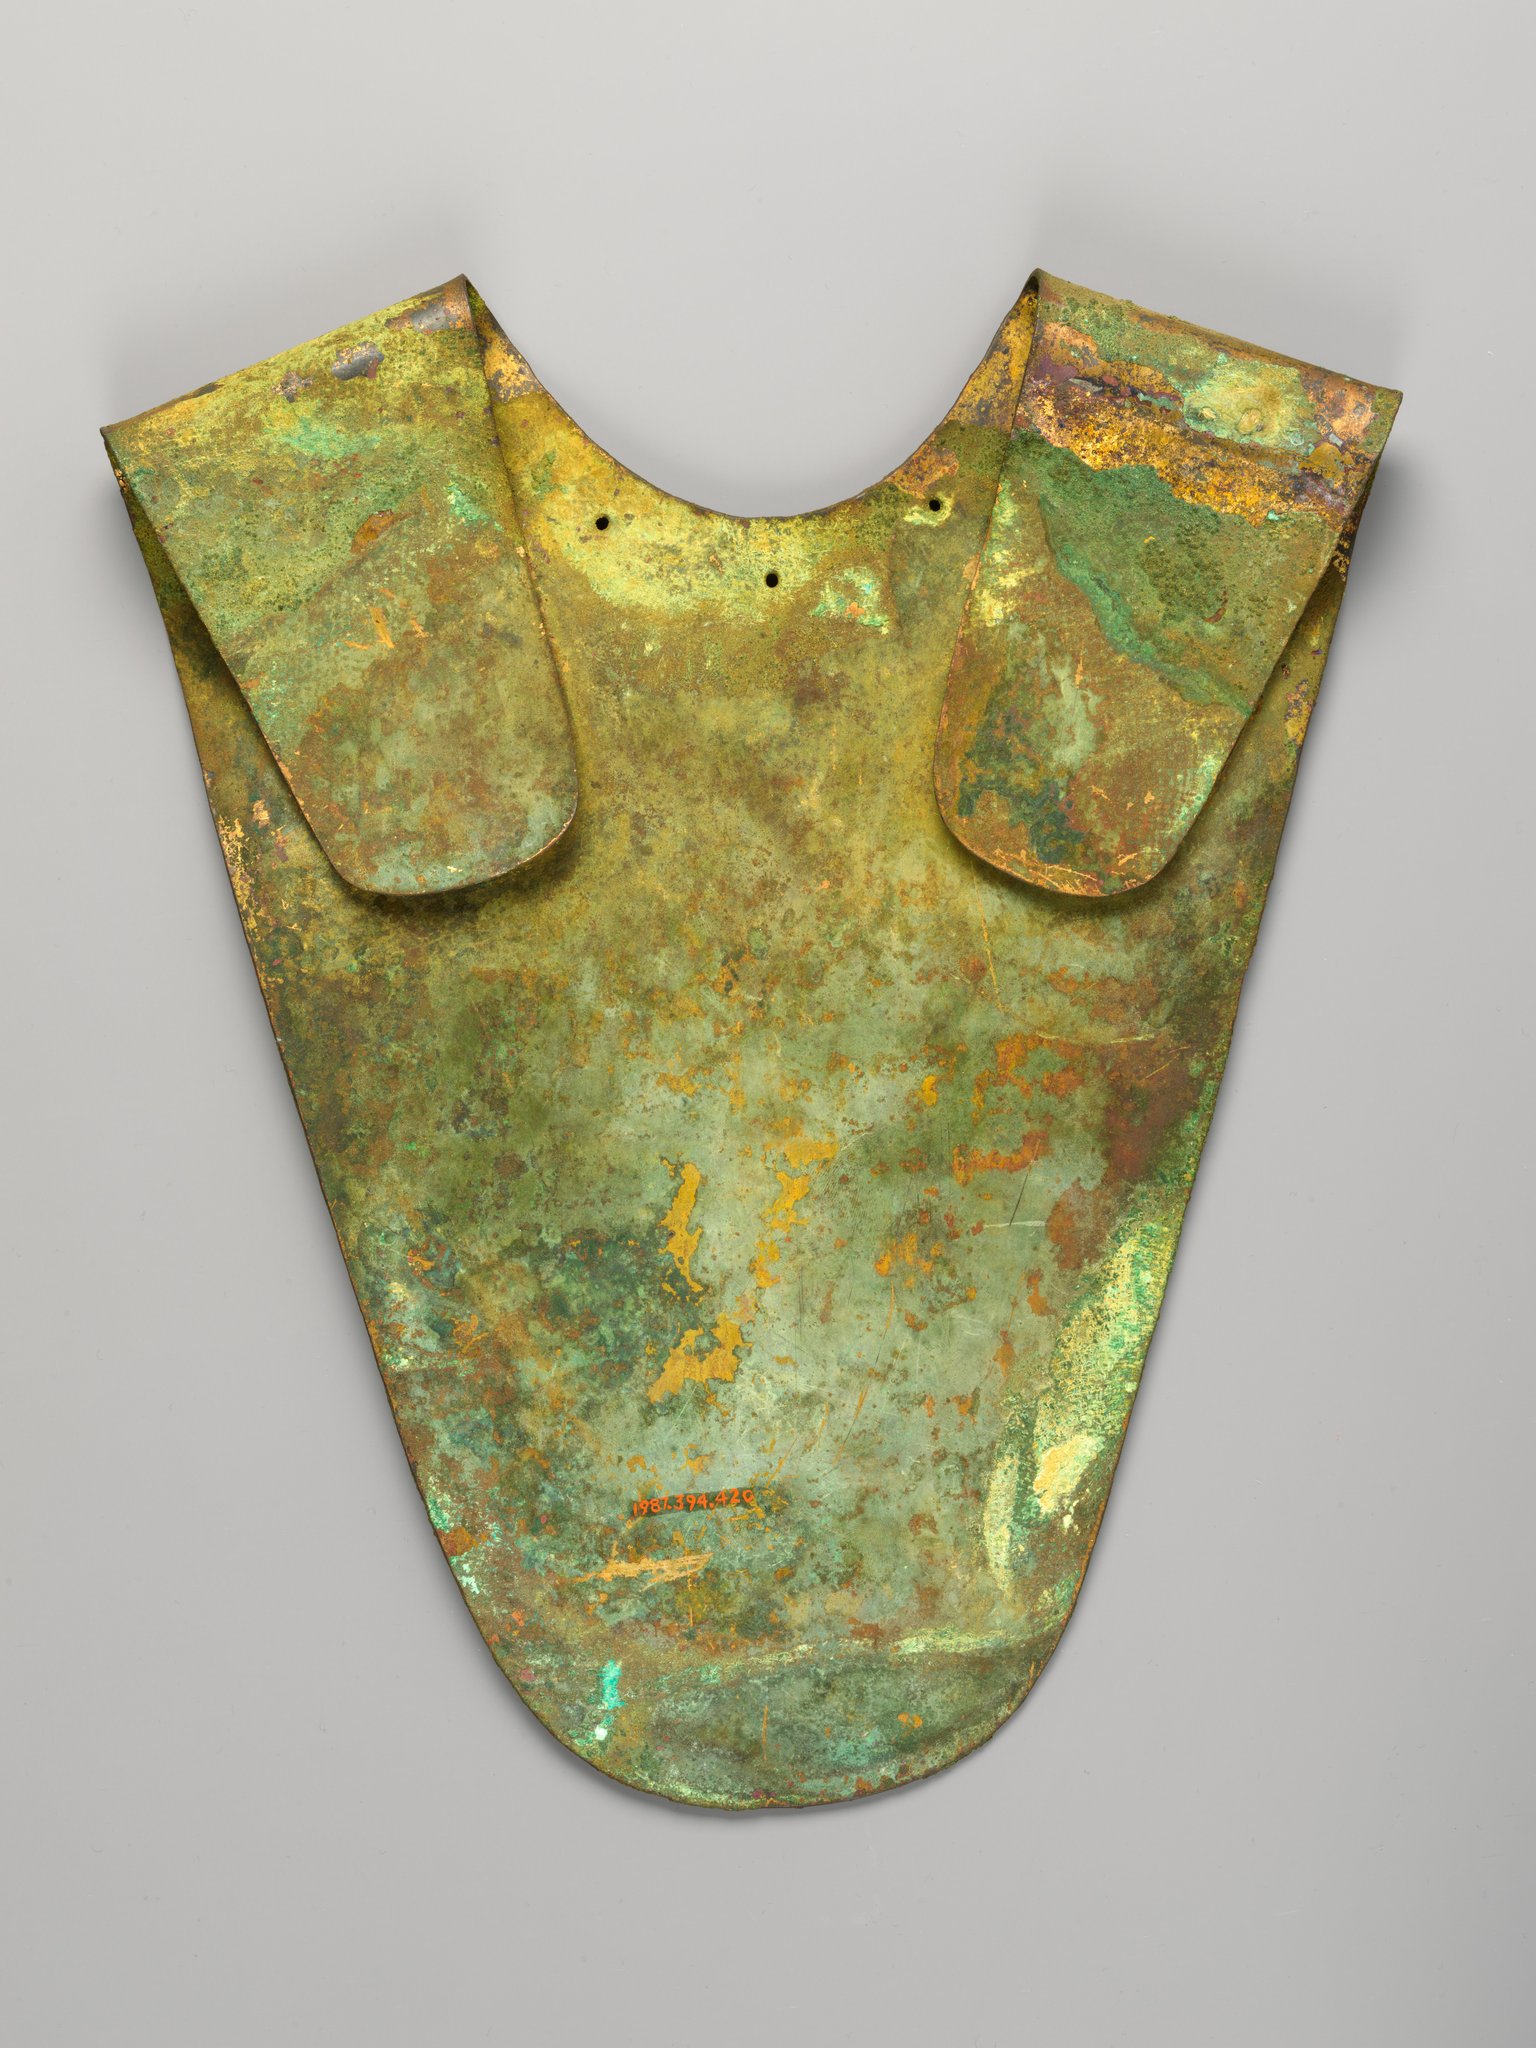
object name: pectoral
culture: vicús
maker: vicús artist(s)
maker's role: artist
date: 100 BCE-500 CE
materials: copper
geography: peru